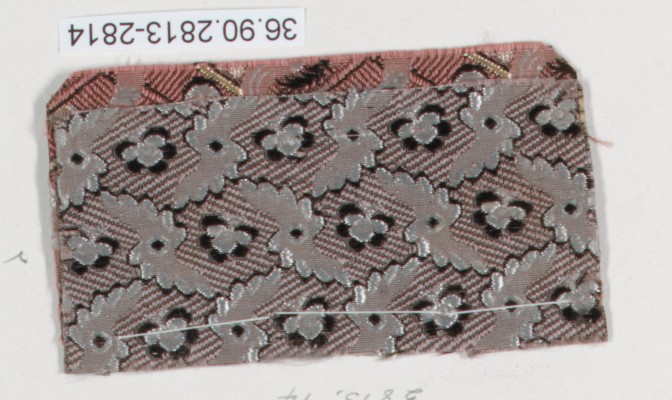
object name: piece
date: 1801-1900